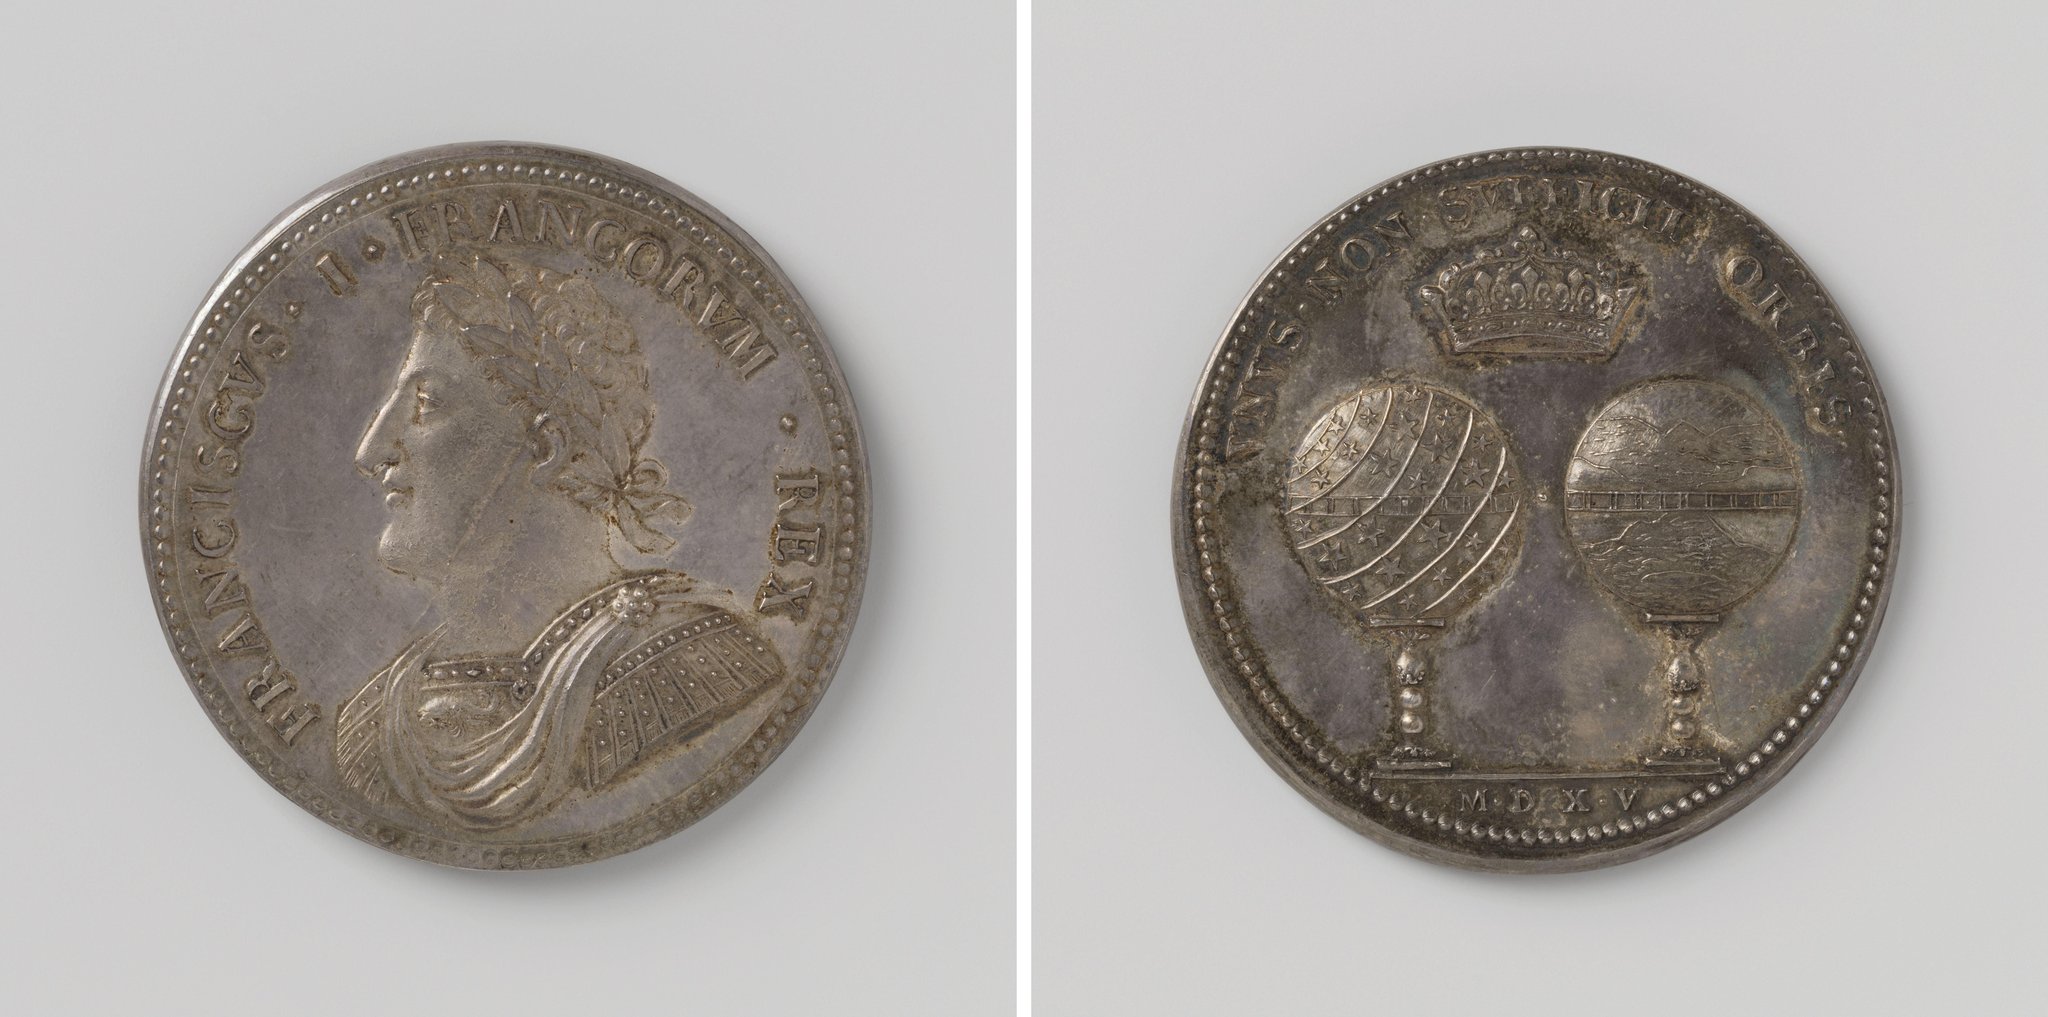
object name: history medal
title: Frans I van Frankrijk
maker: pierre regnier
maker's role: medailleur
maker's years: 1577-1640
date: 1607-1640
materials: silver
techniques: striking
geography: paris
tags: frans i van valois-angoulême (koning van frankrijk), globe, star-globe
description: Zilveren penning. Voorzijde: borststuk man met lauwerkrans binnen omschrift. Keerzijde: wereldbol en hemelglobe onder kroon binnen omschrift, boven opschrift